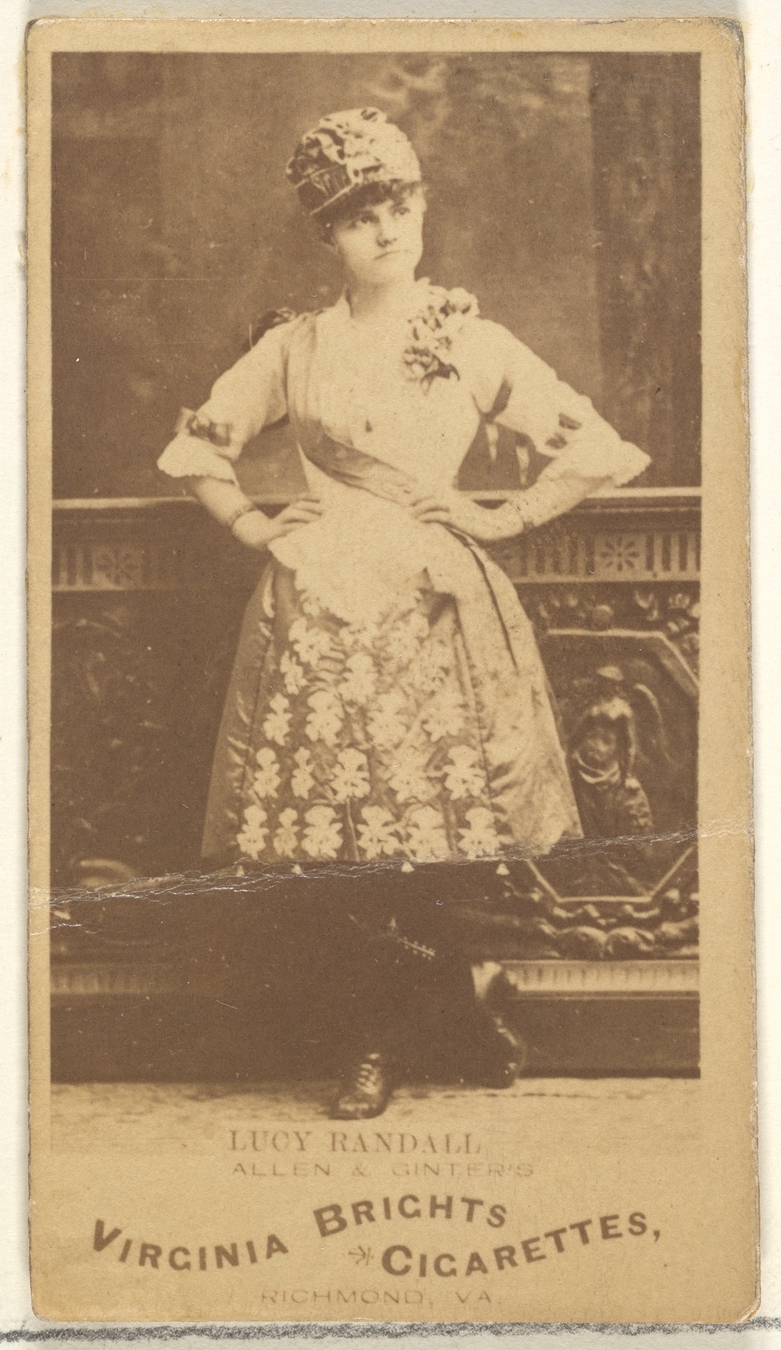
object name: photograph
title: Lucy Randall, from the Actors and Actresses series (N45, Type 1) for Virginia Brights Cigarettes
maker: allen & ginter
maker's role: publisher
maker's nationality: american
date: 1888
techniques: albumen silver print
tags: portraits,women,actresses